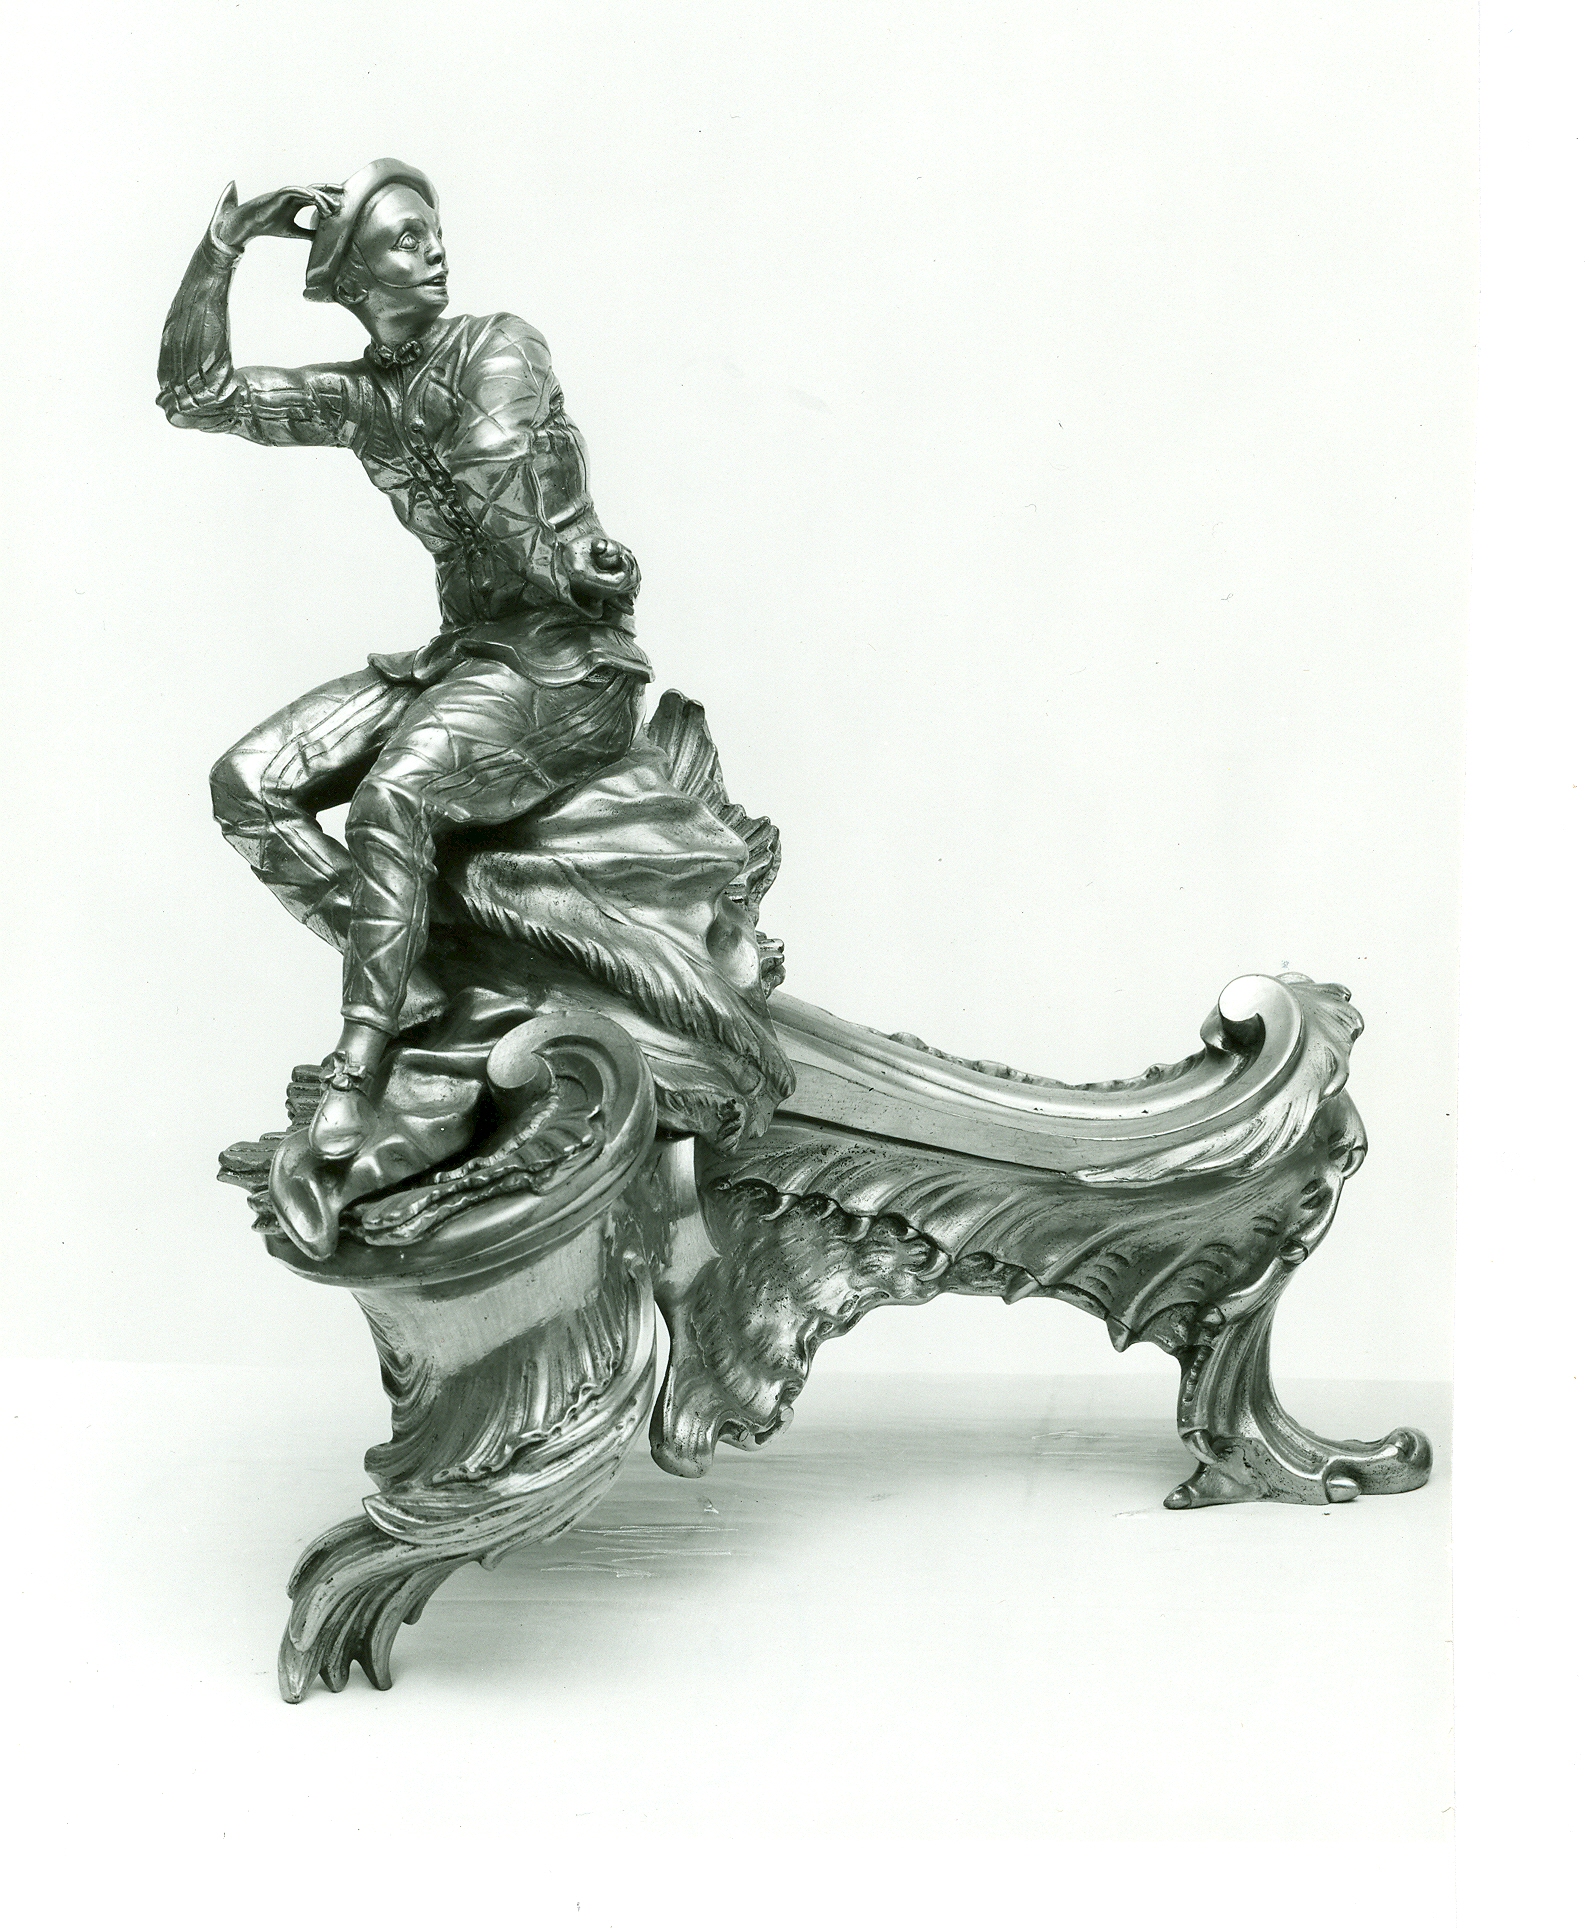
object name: andiron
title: Chenet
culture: french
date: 1851-1900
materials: gilt bronze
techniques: casting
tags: men